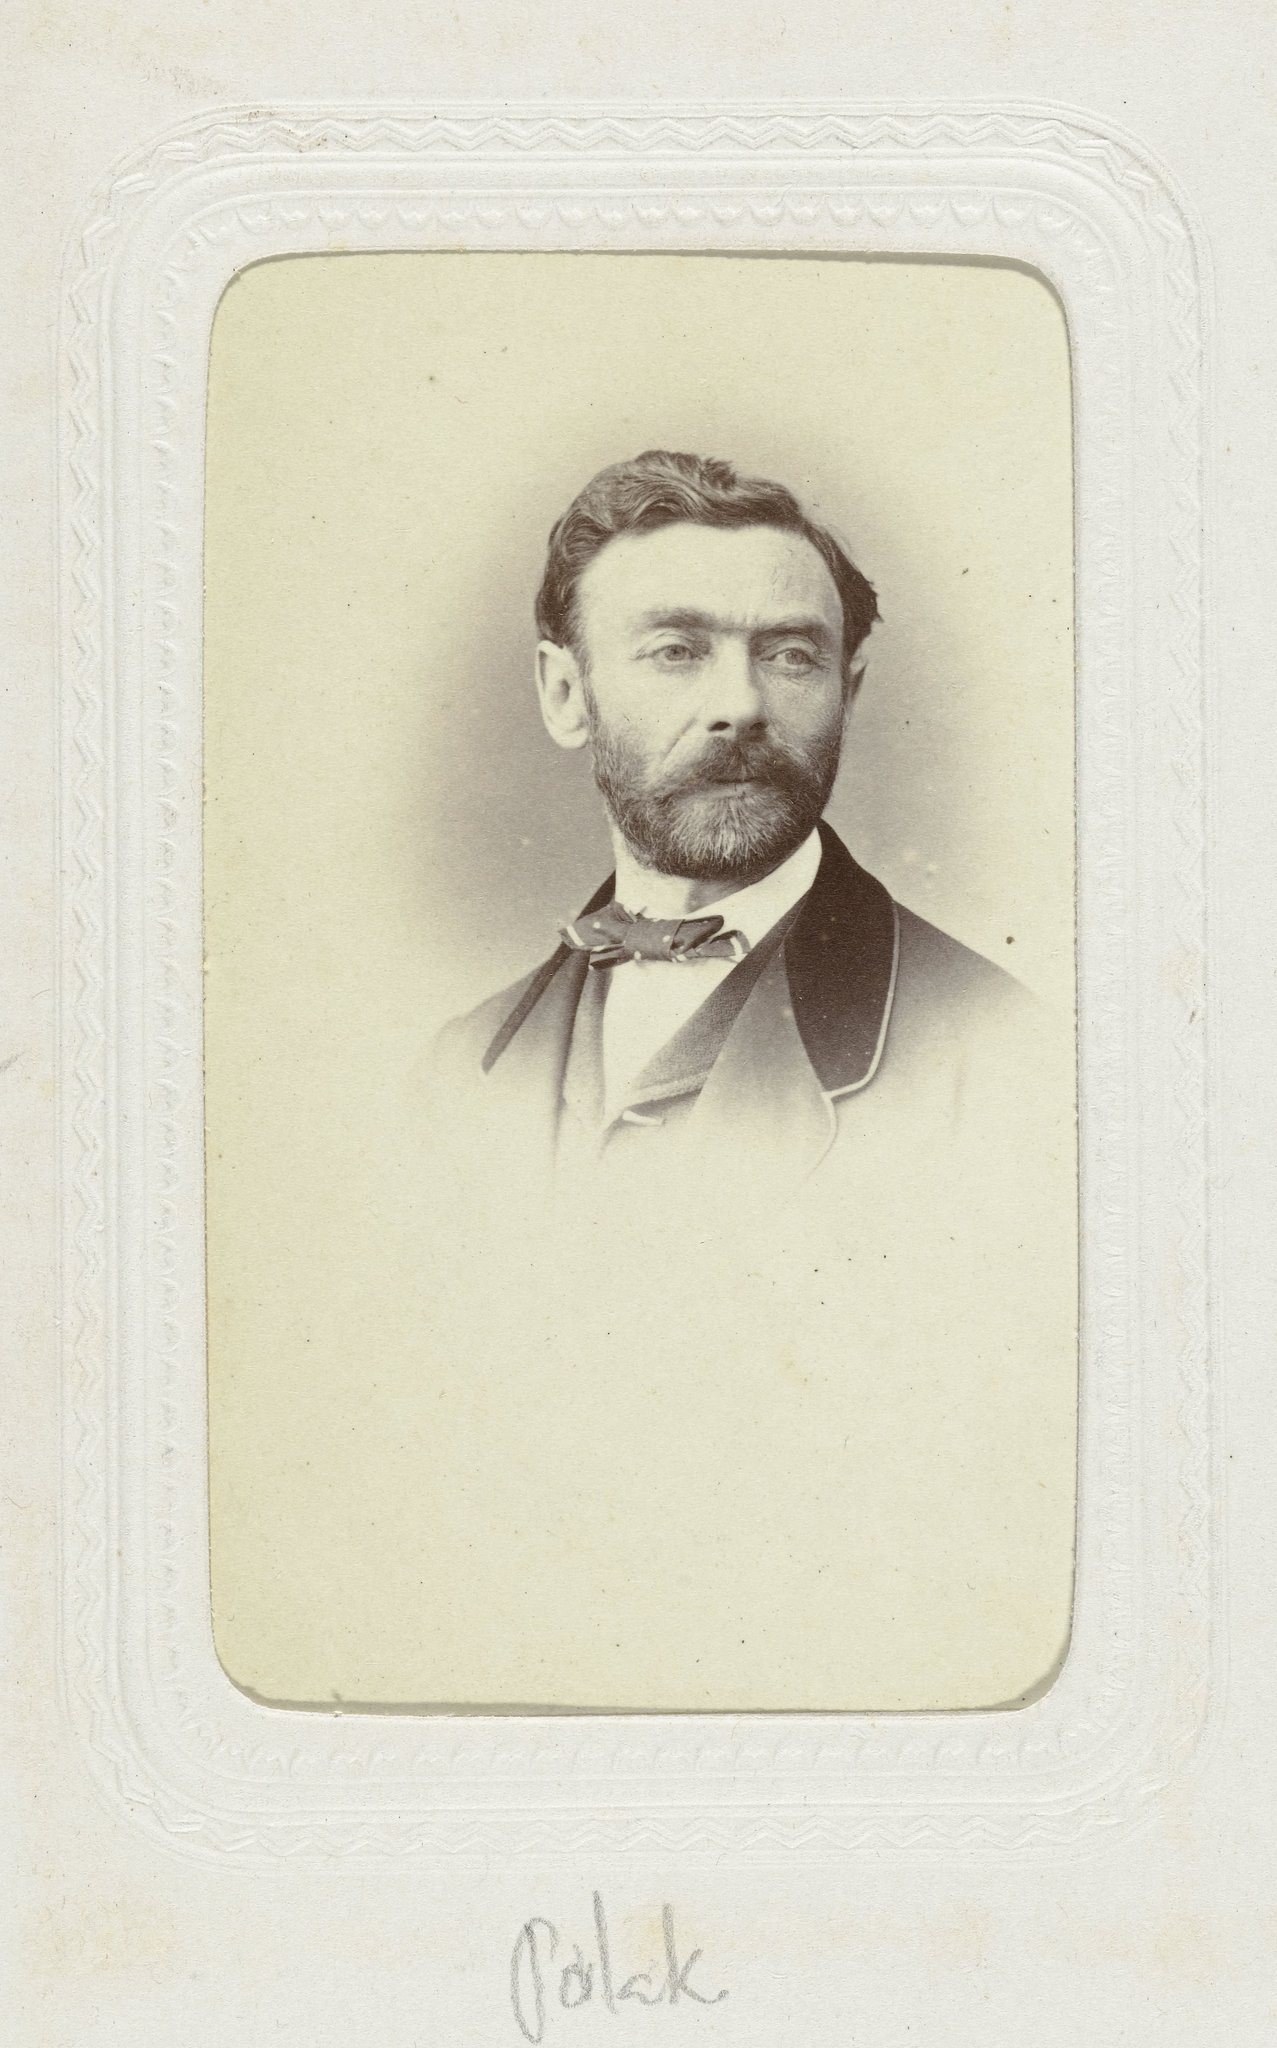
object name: carte de visite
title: Studioportret van een man met snor en baard in een jasje met fluwelen kraag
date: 1863-1866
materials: cardboard, paper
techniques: albumen print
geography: istanbul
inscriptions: name: ‘Polak’, inscription: ‘Cogito ergo sum - Je ne connais pas vos savants, ou ils n'existend pas.’, name: ‘Abdullah freres’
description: De afgebeelde man is vermoedelijk de heer Polak.